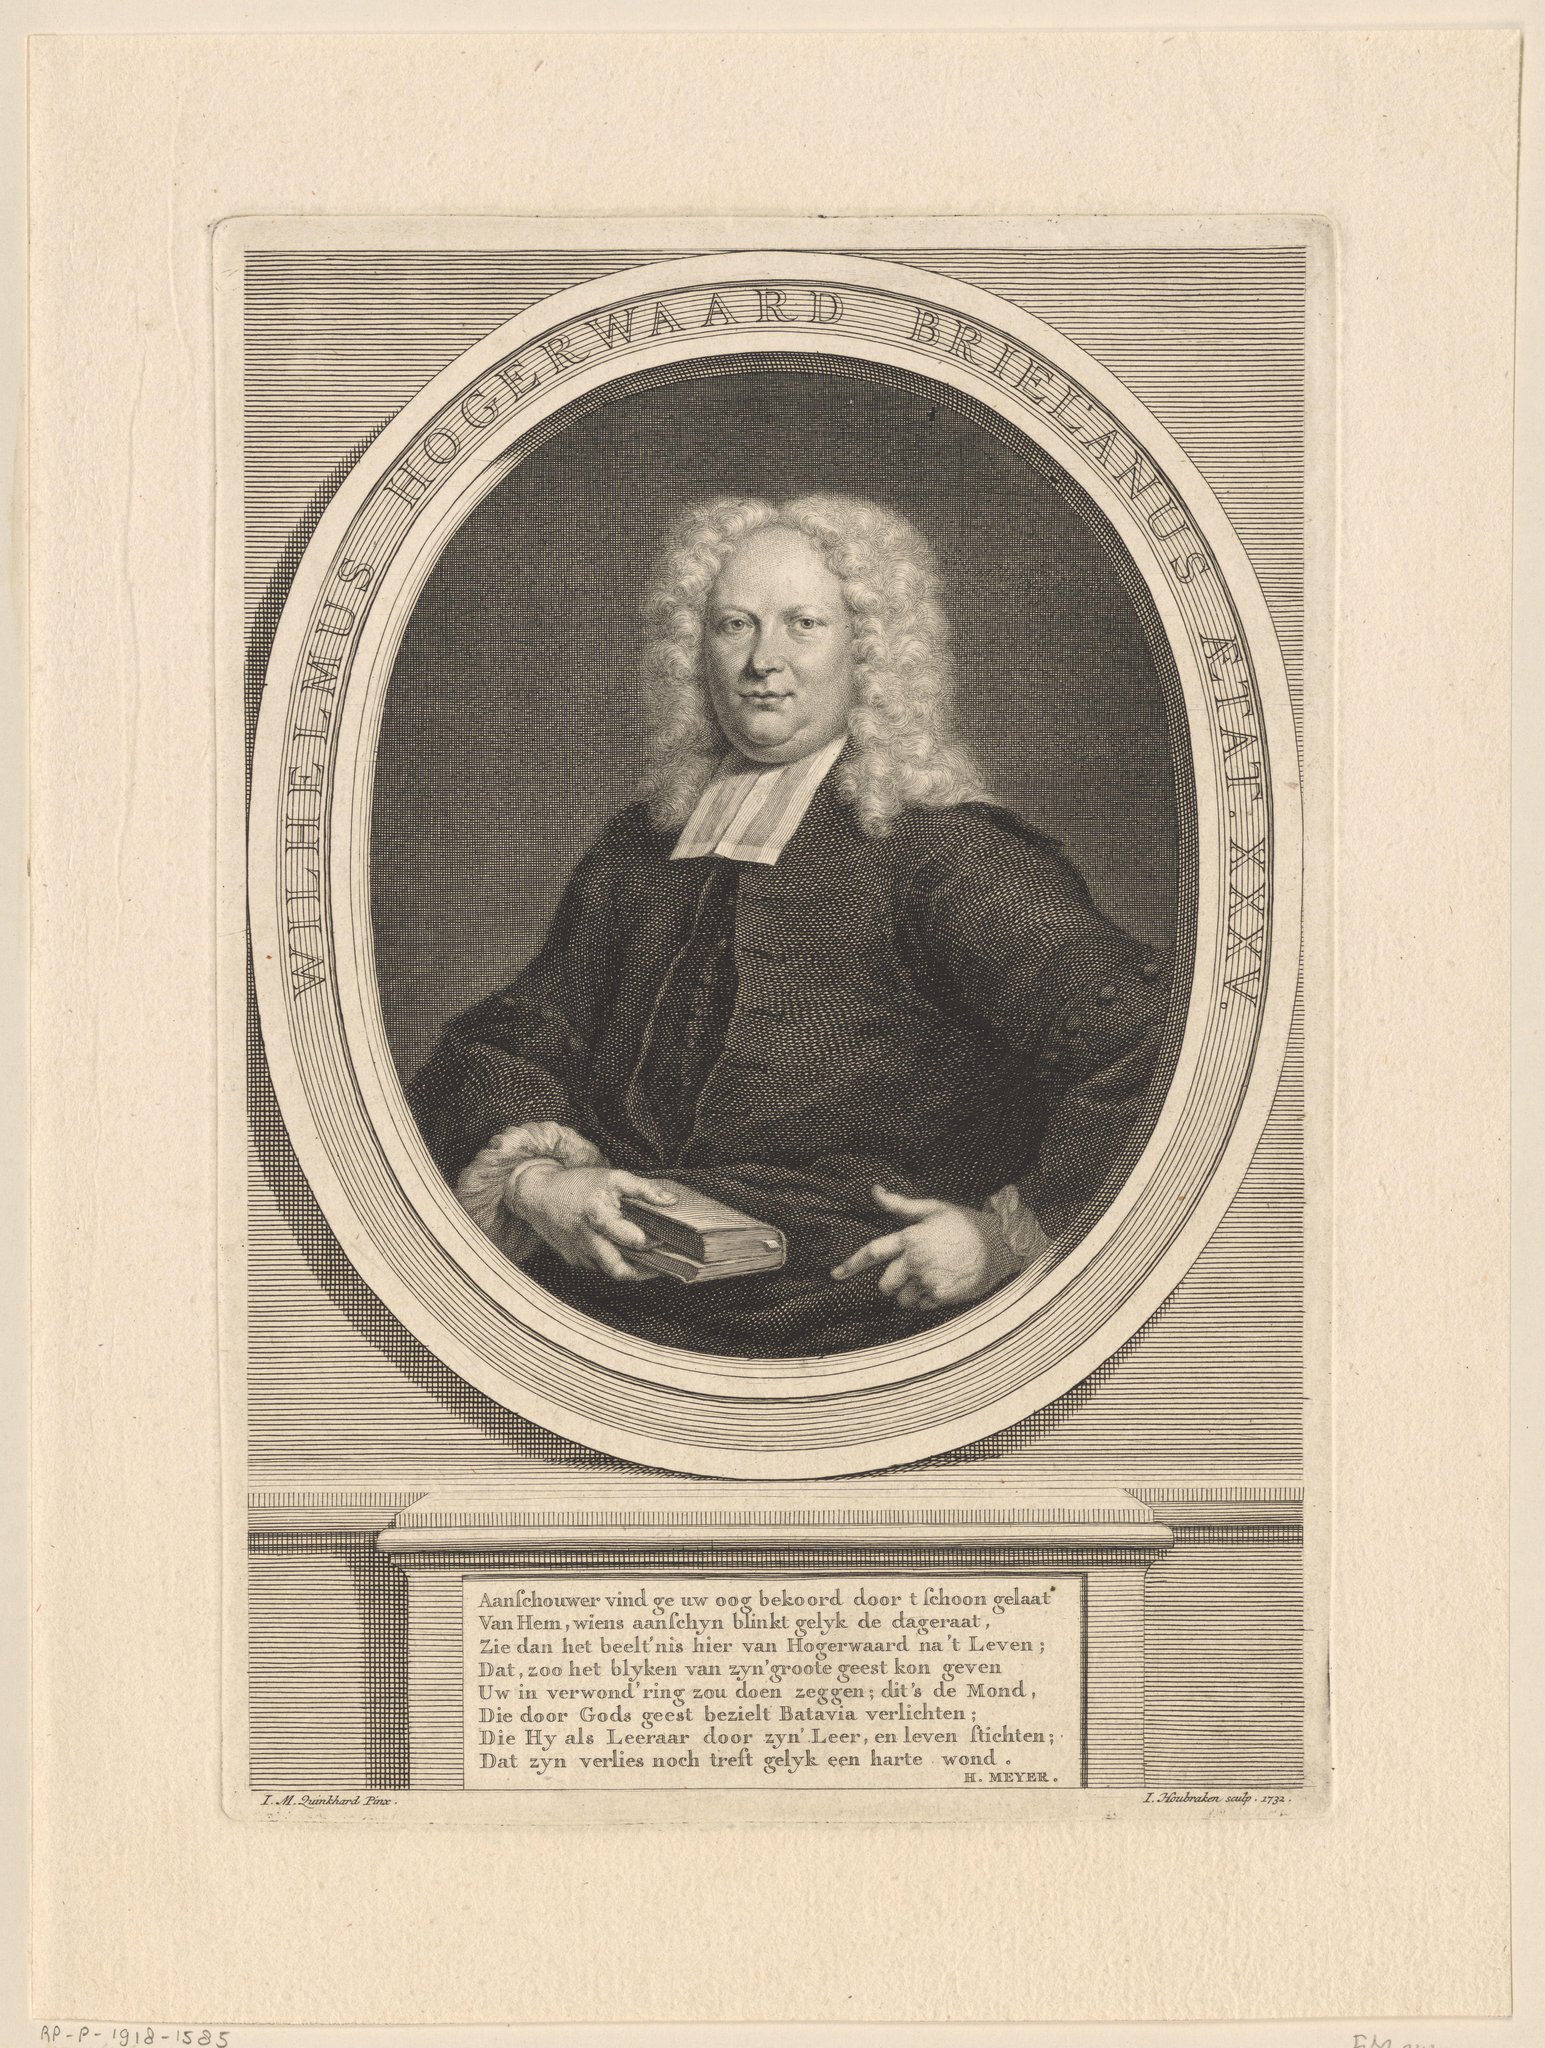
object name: print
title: Portret van Willem Hogerwaard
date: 1732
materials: paper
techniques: engraving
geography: amsterdam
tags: brielle, the hague, historical persons, book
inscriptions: collector's mark: Lugt 2233